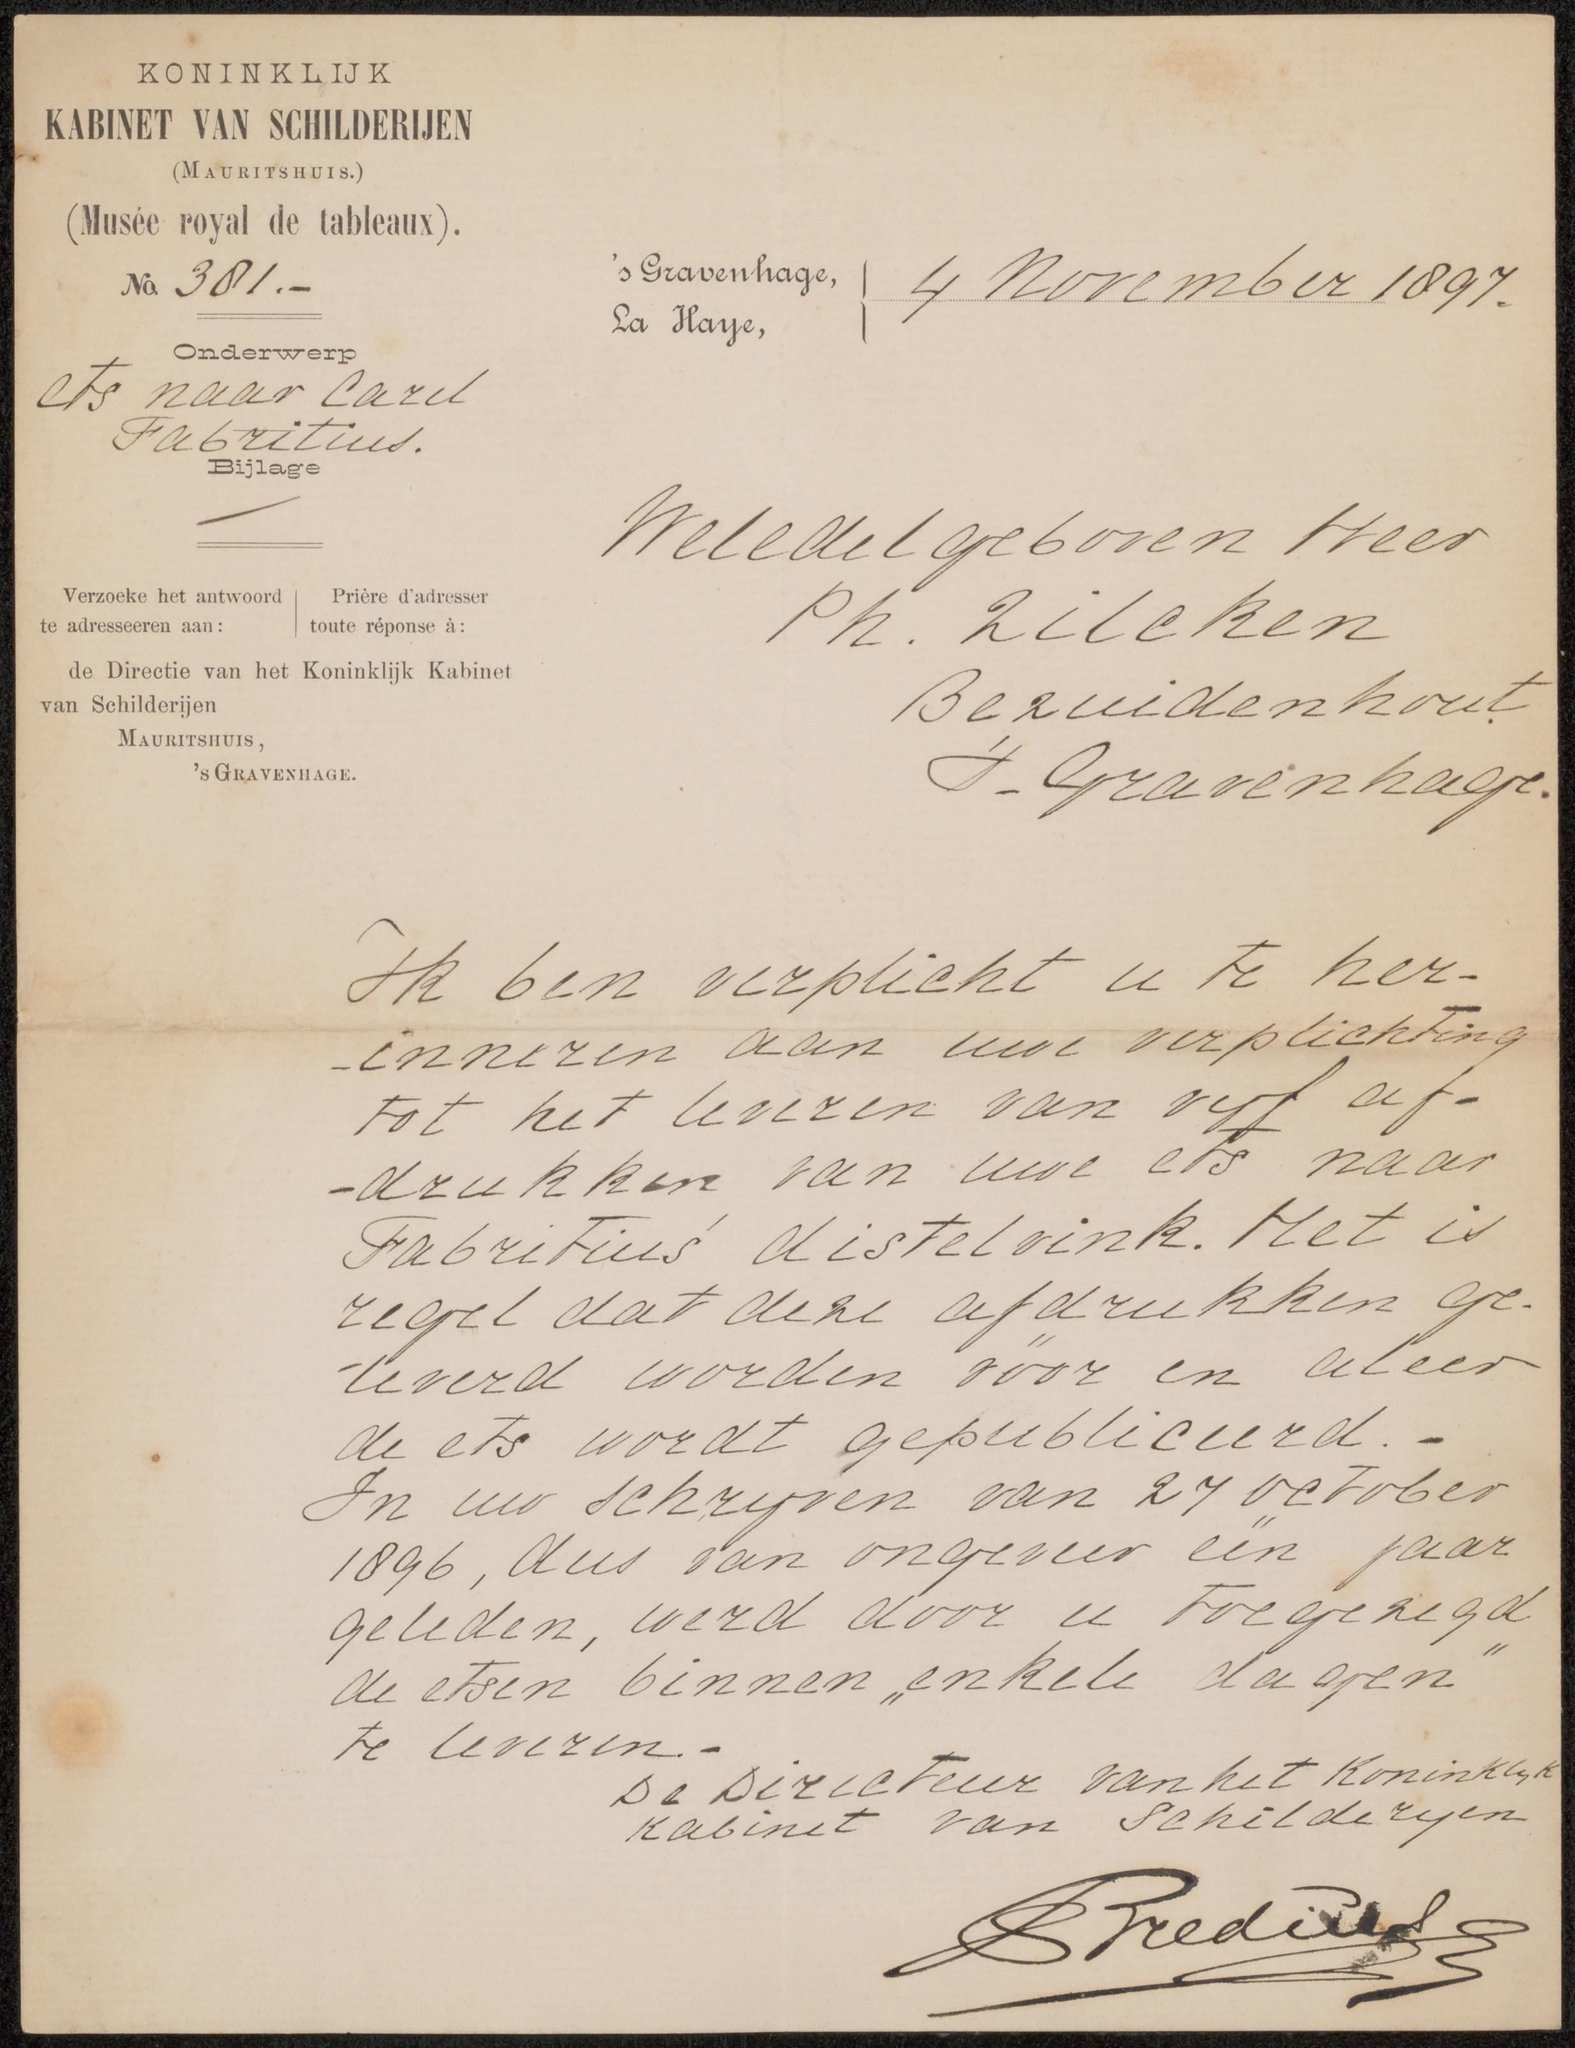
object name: letter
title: Brief aan Philip Zilcken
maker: abraham bredius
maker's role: kunsthistoricus, museumdirecteur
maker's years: 1855-1946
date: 1897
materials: ink, paper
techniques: pen, printing, writing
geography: the hague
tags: delft, carel fabritius, painter, draughtsman, philip zilcken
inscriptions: collector's mark: ‘RPK’